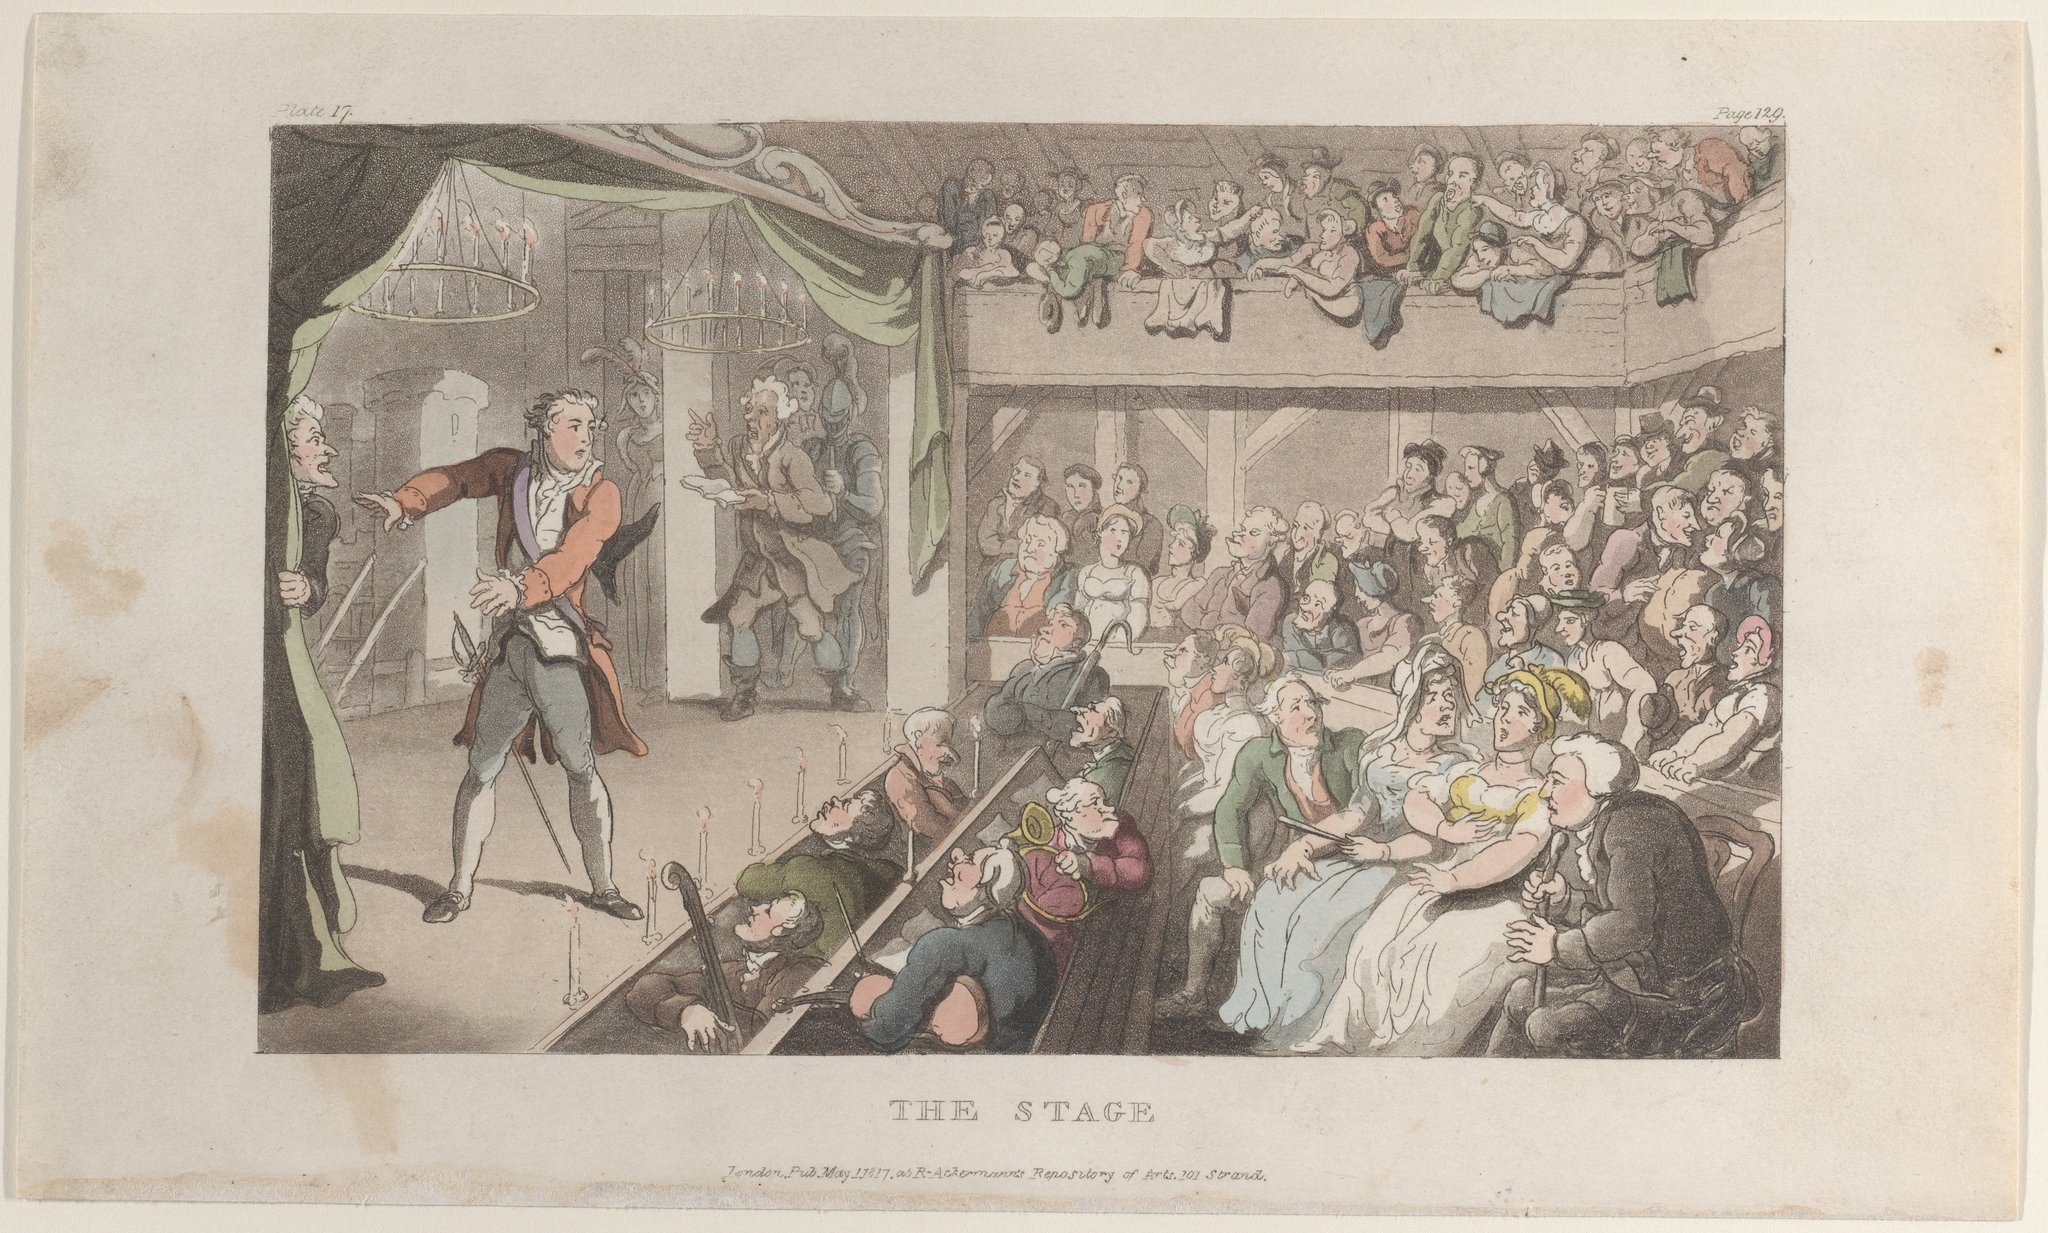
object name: print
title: The Stage. George Primrose as "Horatio"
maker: thomas rowlandson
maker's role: artist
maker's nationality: british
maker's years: 1757-1827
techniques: aquatint, etching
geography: london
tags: performance,theatre,men,women,actors